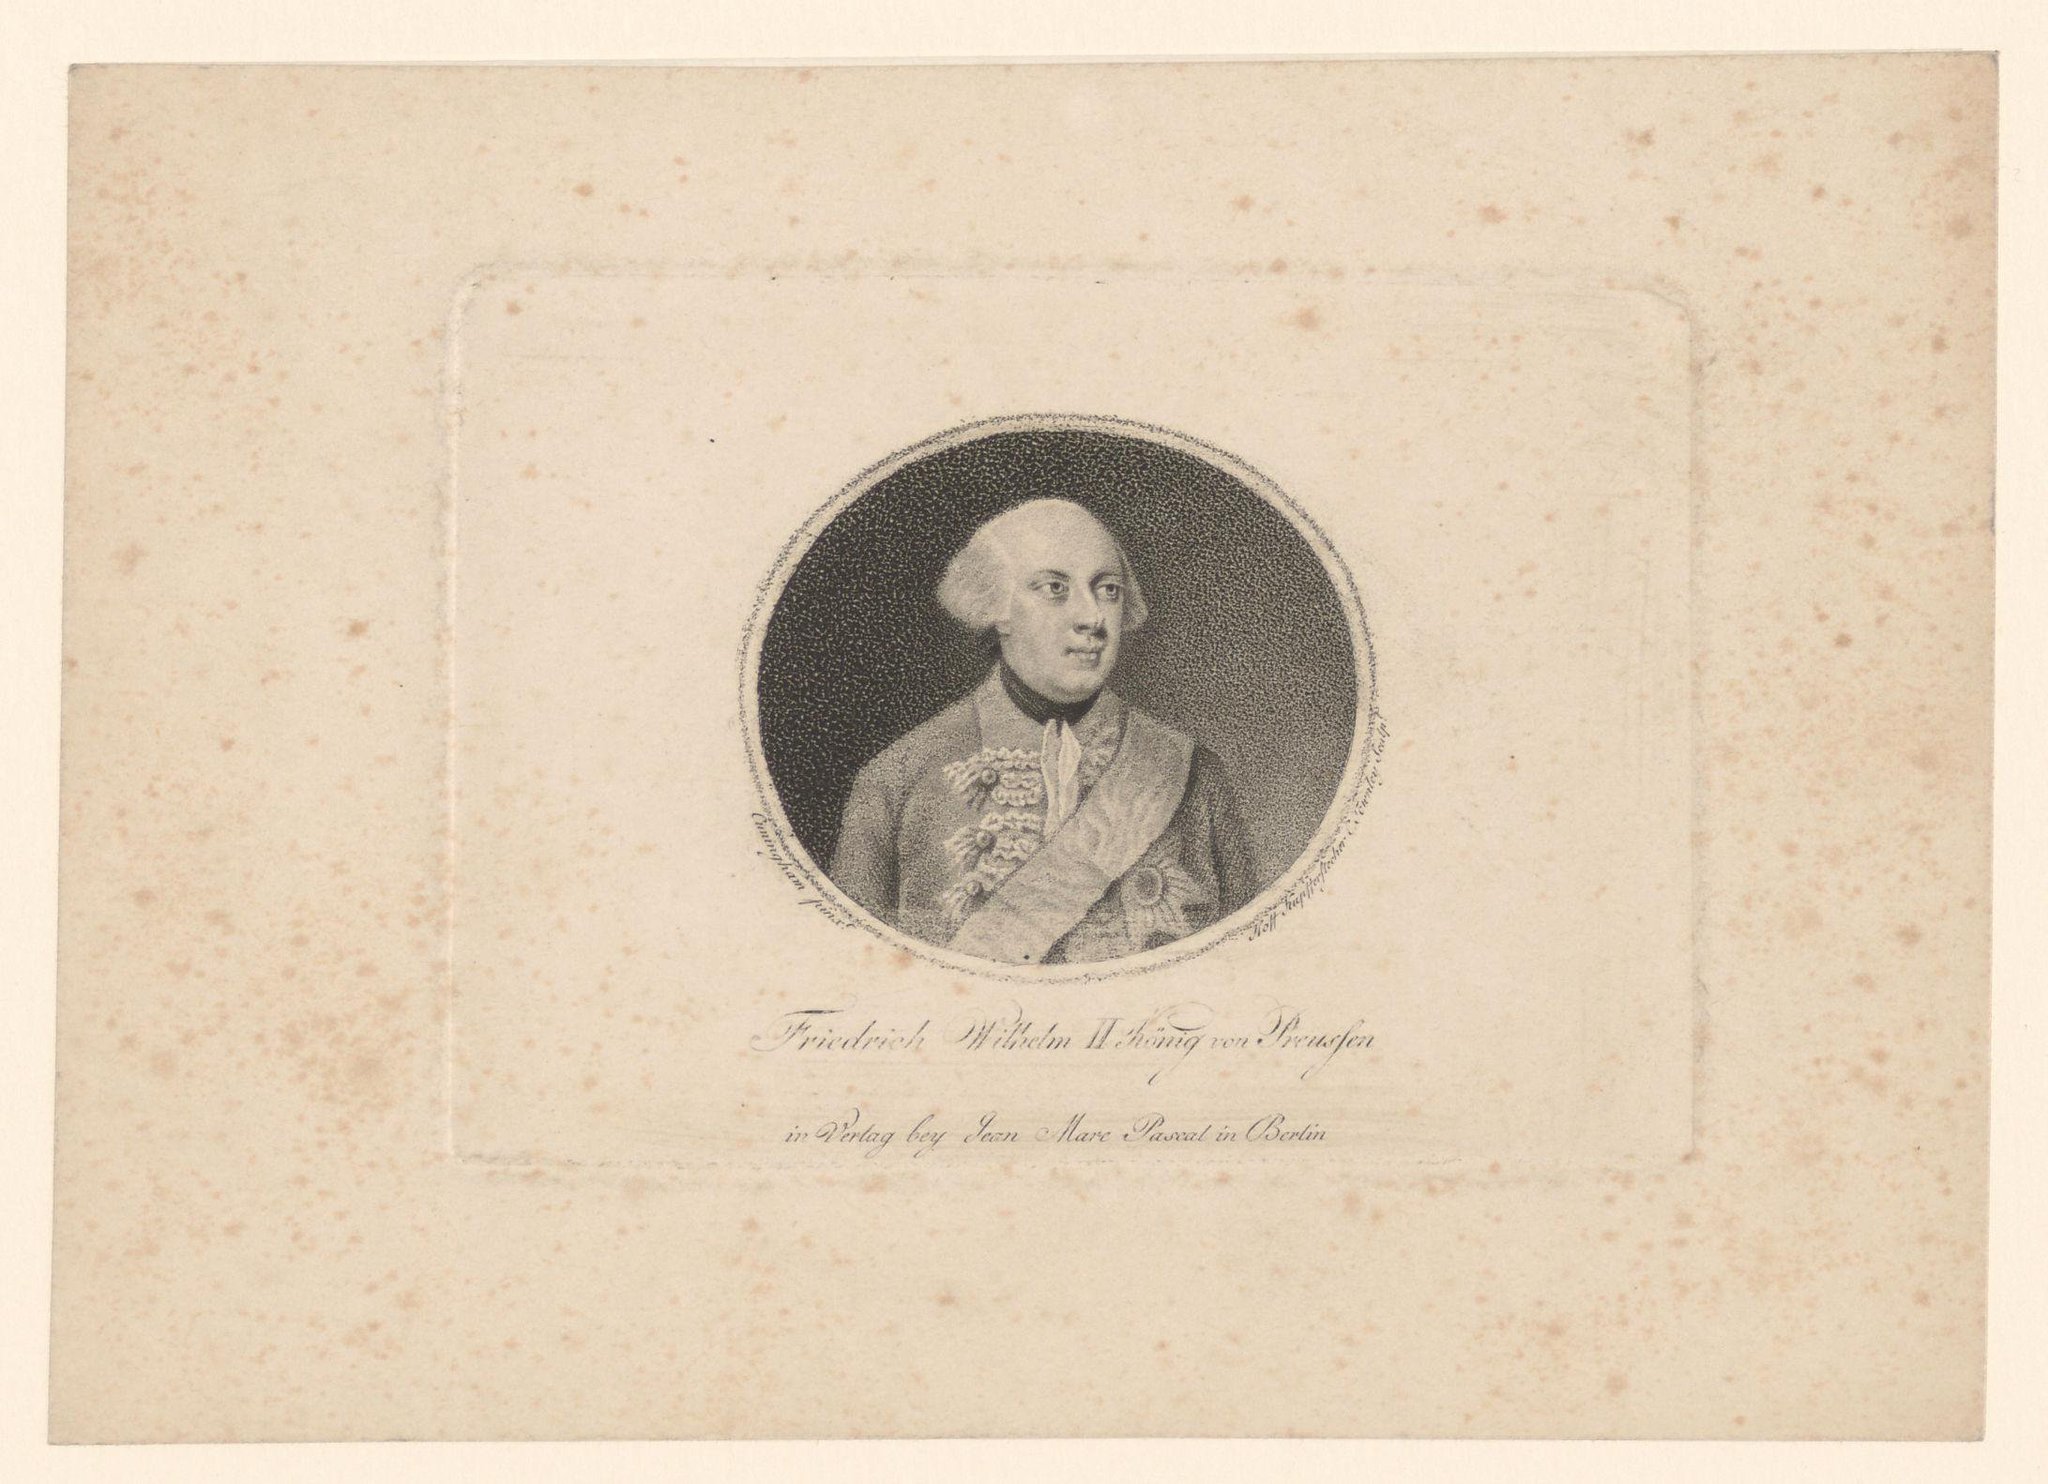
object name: print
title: Friedrich Wilhelm II König von Preussen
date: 1786-1797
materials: paper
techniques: engraving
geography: berlin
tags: berlin, frederik willem ii (koning van pruisen), historical persons, king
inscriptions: collector's mark: Lugt 2228